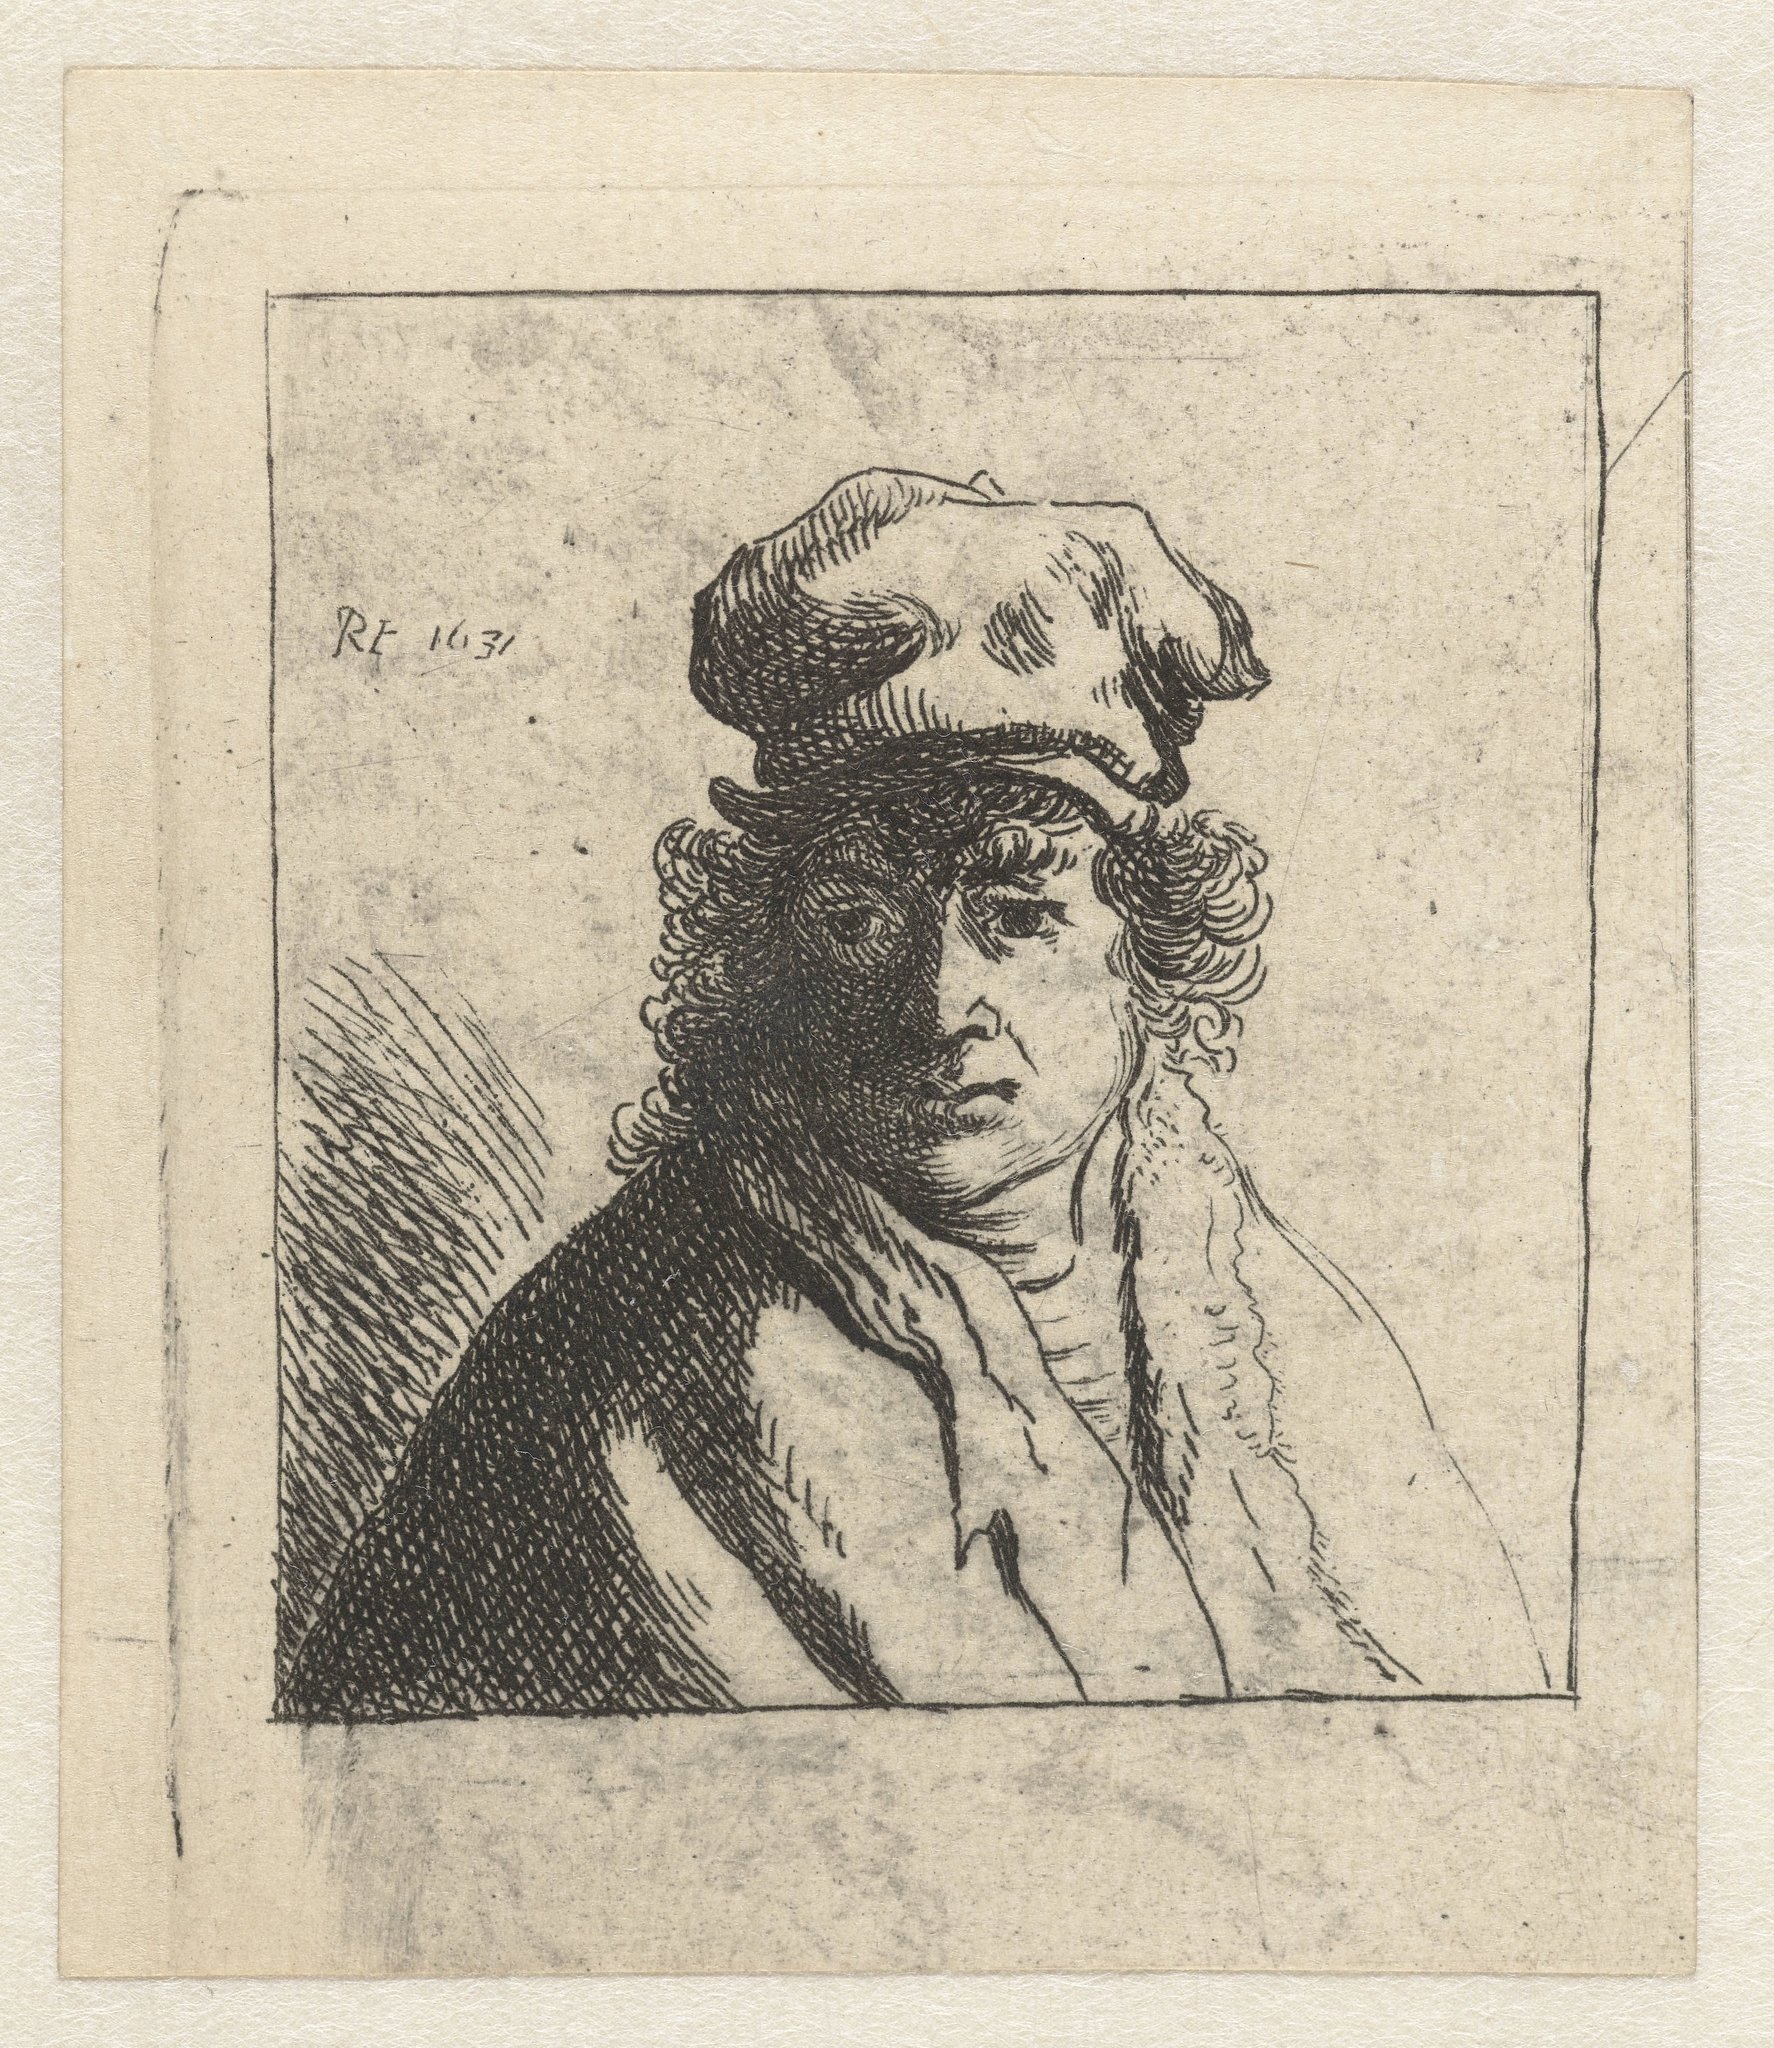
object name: print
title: Young man in cap: bust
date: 1807-1808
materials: paper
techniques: etching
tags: youth, adolescent, head-gear: cap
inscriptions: collector's mark: Lugt 2228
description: Prent gebruikt in: Basan, H.L. Recueil de quatre-vingt-cinq estampes originales, tetes, paysages et différens sujets, dessinées et gravées par Rembrandt. Parijs: Henry Louis Basan, 1807-1808.